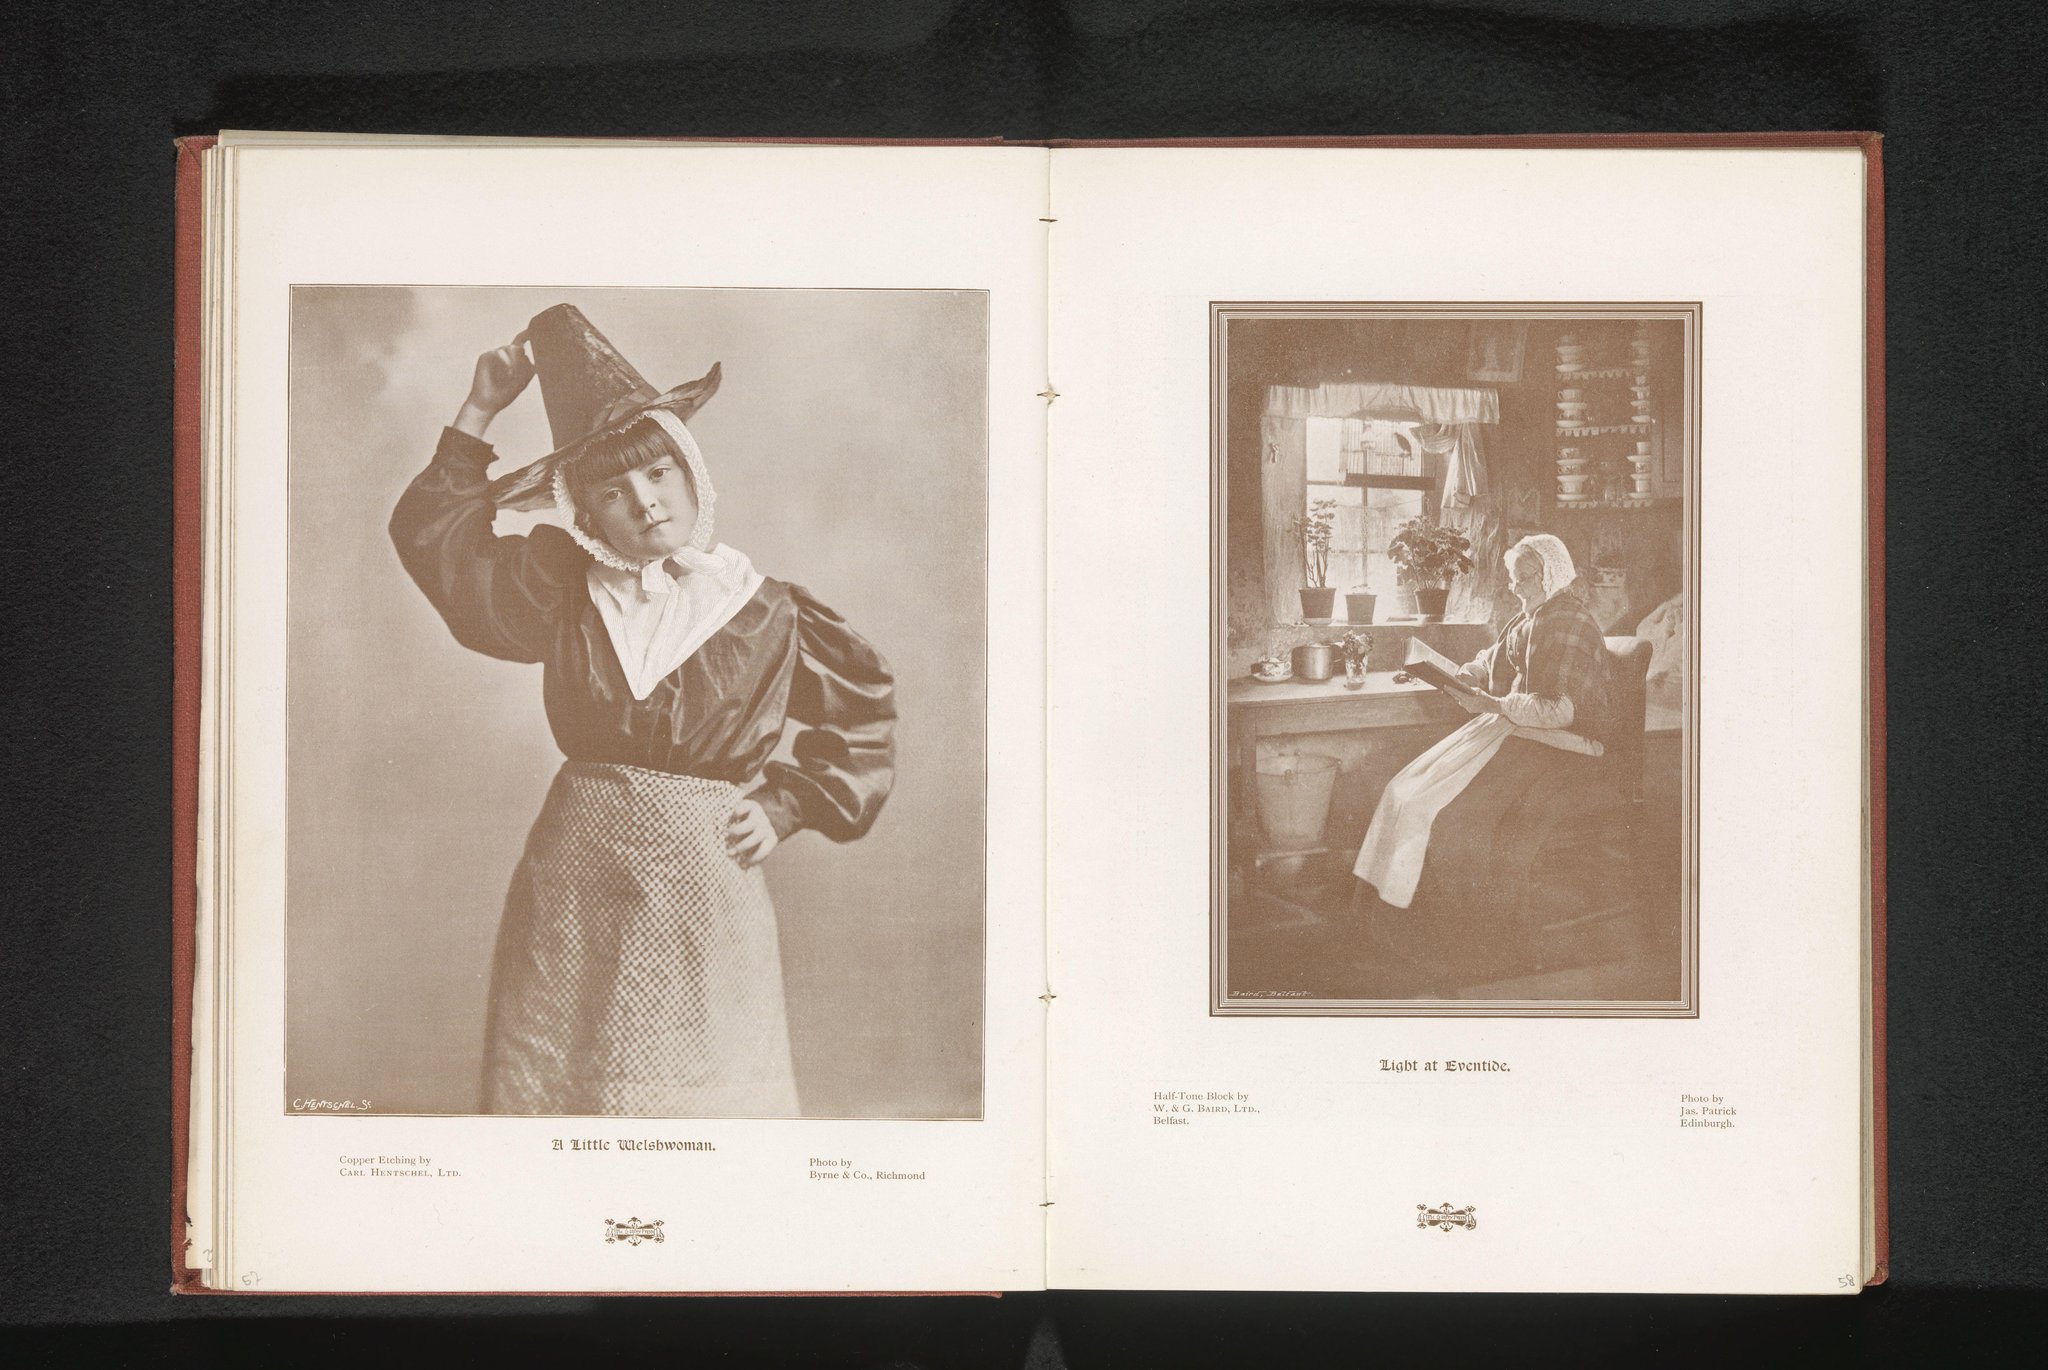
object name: page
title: Lezende vrouw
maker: james patrick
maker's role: fotograaf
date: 1895-1900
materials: paper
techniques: autotype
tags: reading, historical persons - bb - woman, old woman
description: Prent op derde ongenummerde pagina na pagina 48.